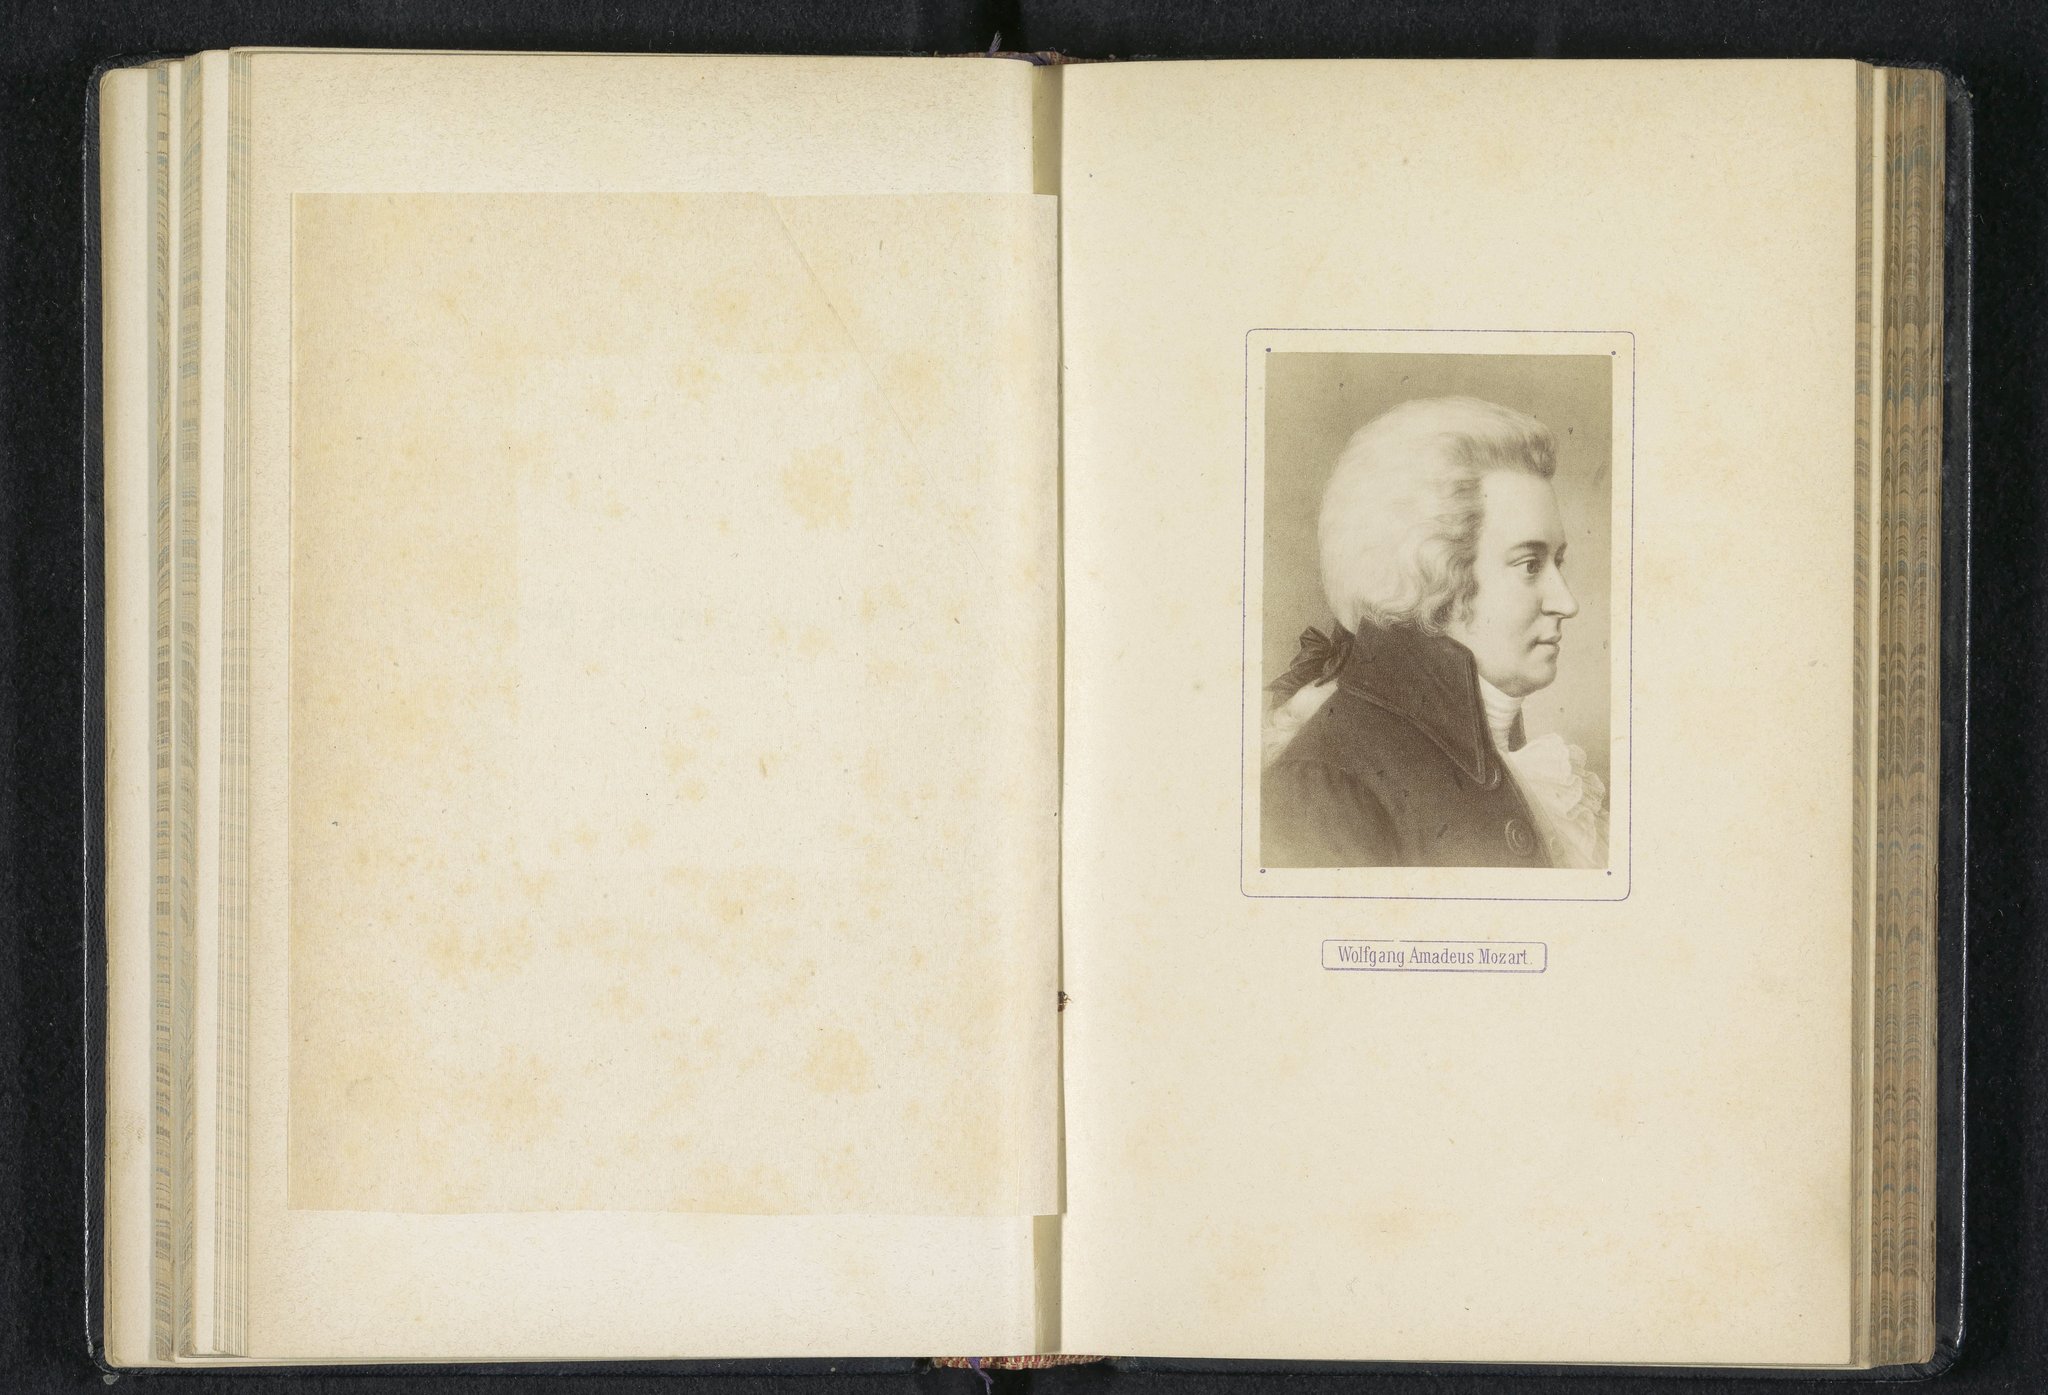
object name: photograph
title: Wolfgang Amadeus Mozart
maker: Anonymous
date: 1866-1876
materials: photographic support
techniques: albumen print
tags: vienna, composer